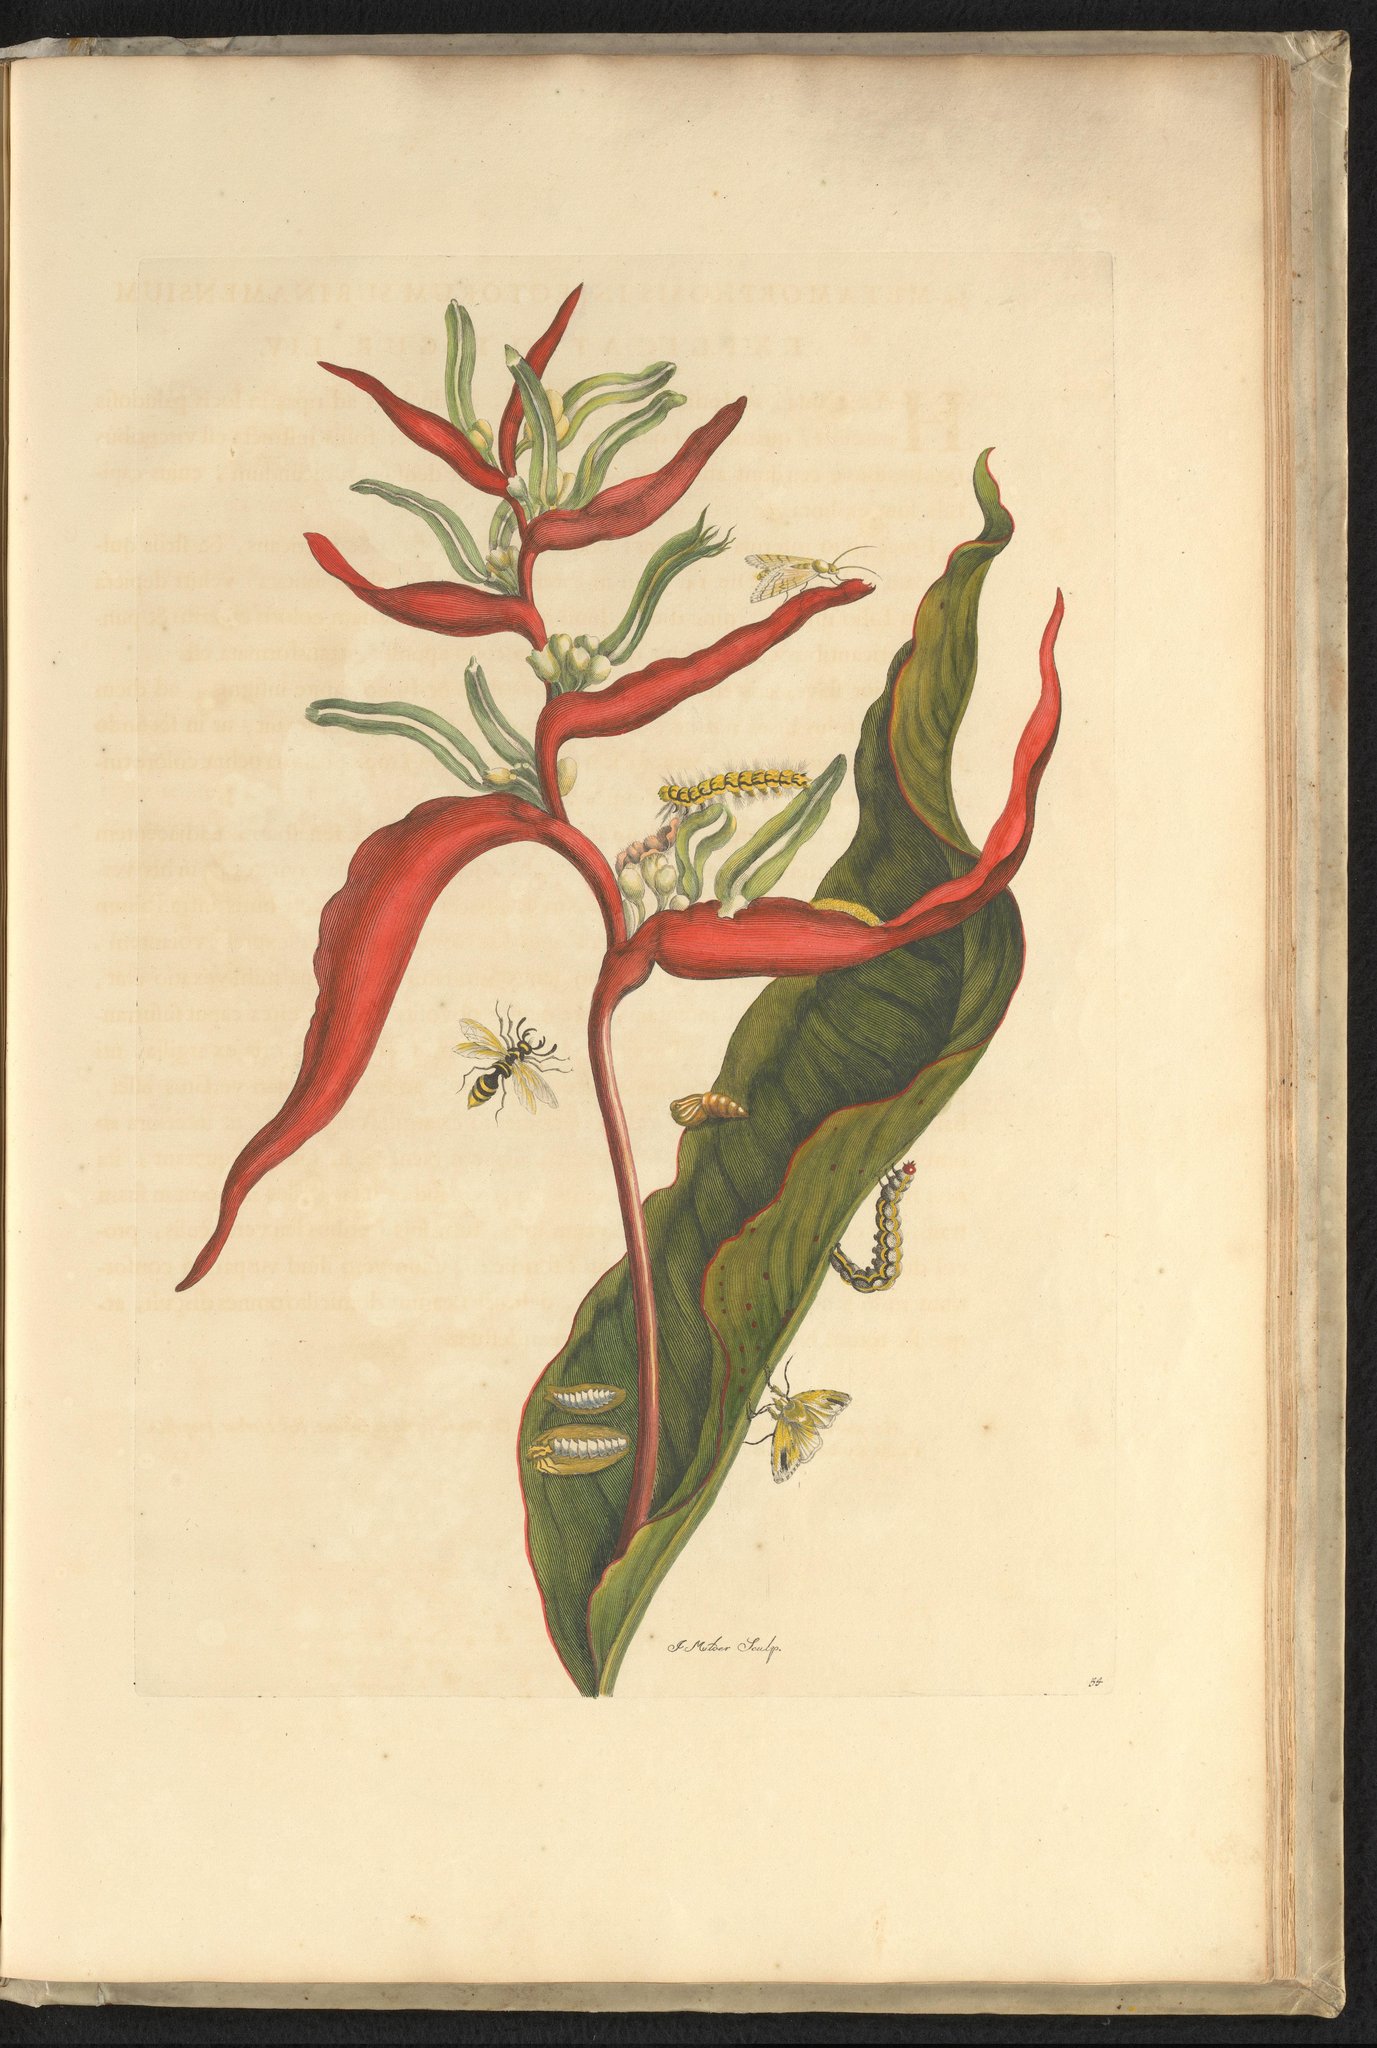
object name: page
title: Plant (Heliconia acuminata) met metselwesp, rupsen en andere insecten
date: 1705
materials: paper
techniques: etching, hand coloring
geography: amsterdam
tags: insects: pupa, insects: moth, insects: wasp, insects: caterpillar, plants and herbs, suriname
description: Rechtsonder genummerd: 54. Prent maakt deel uit van een boek.